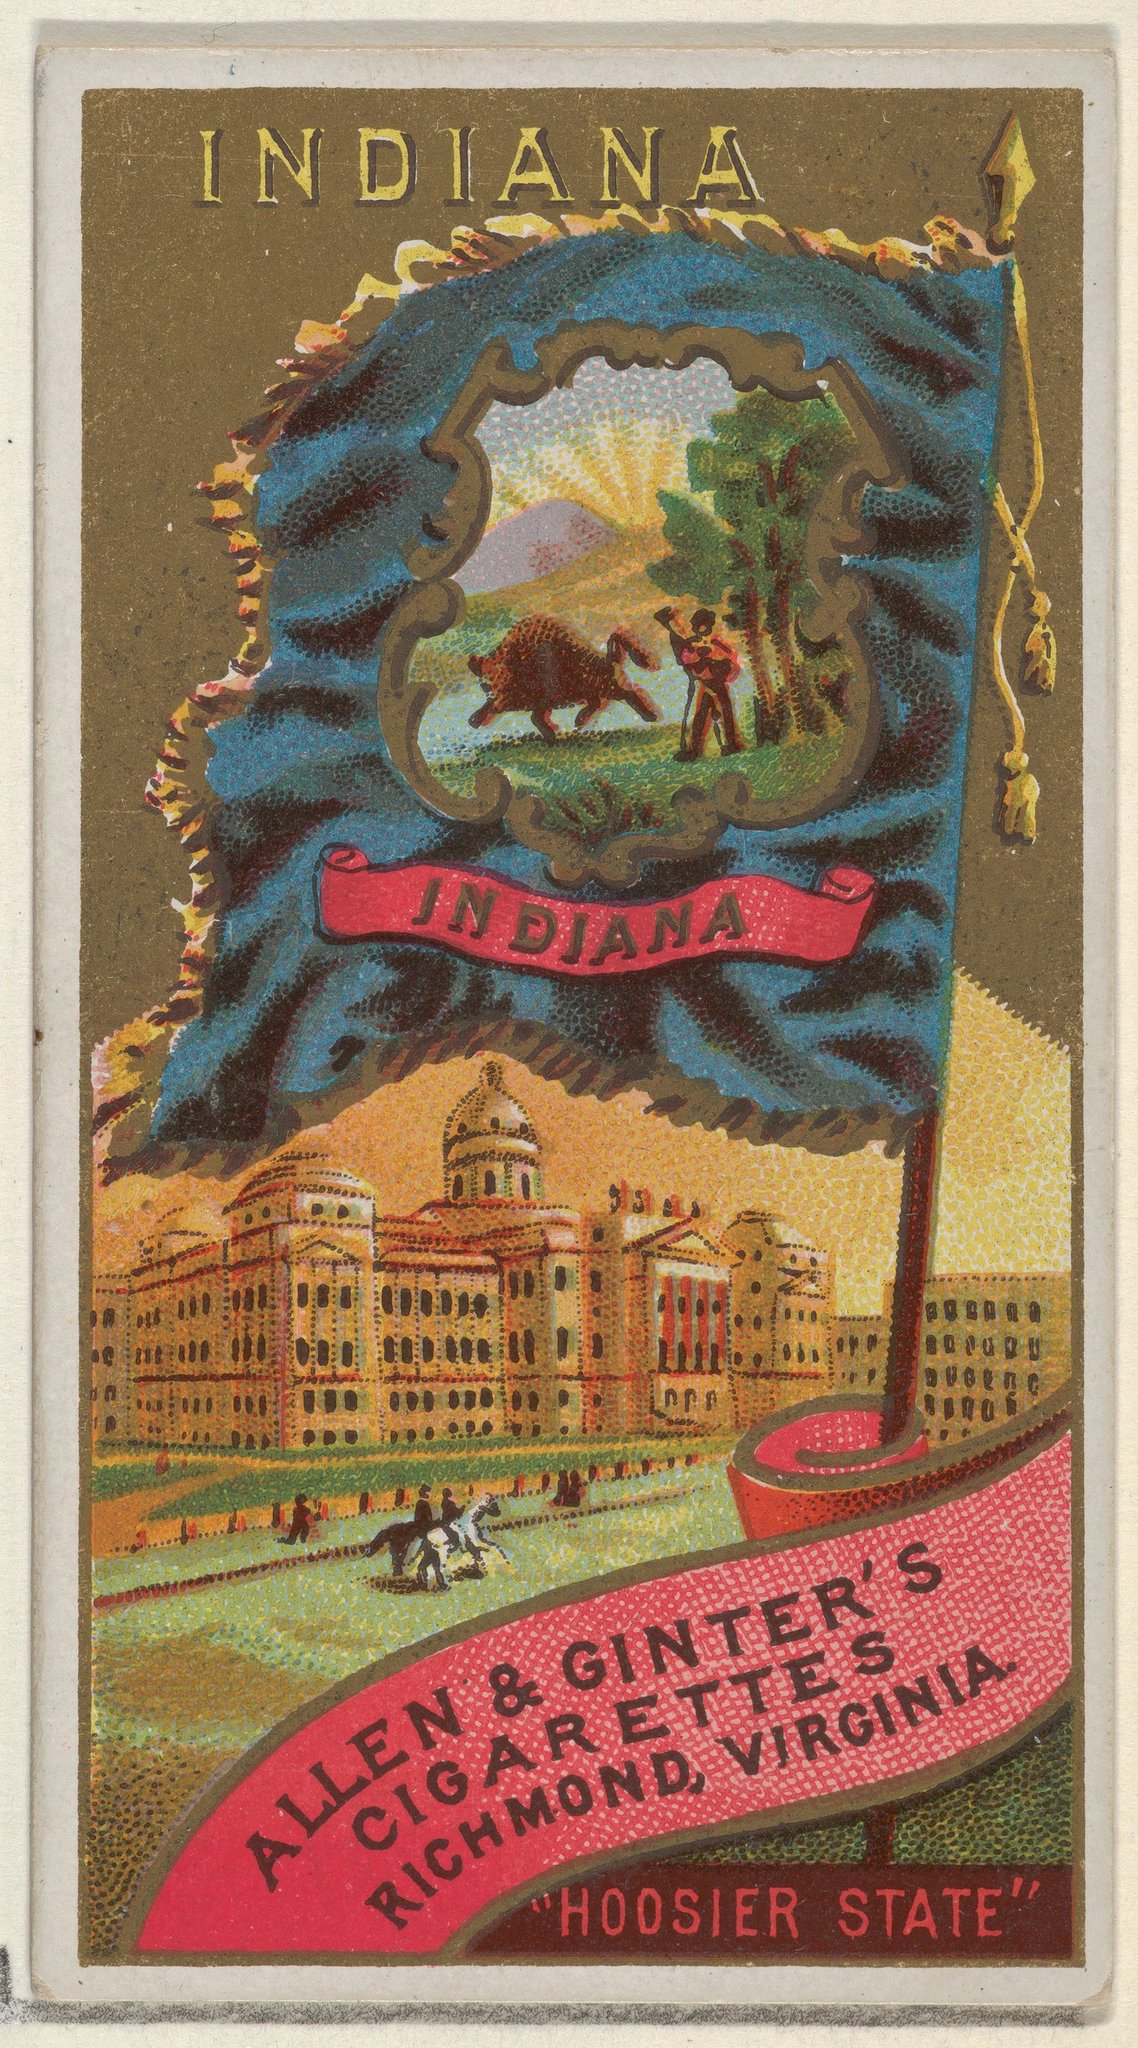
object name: print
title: Indiana, from Flags of the States and Territories (N11) for Allen & Ginter Cigarettes Brands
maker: allen & ginter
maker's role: publisher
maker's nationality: american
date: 1888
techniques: color lithograph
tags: flags